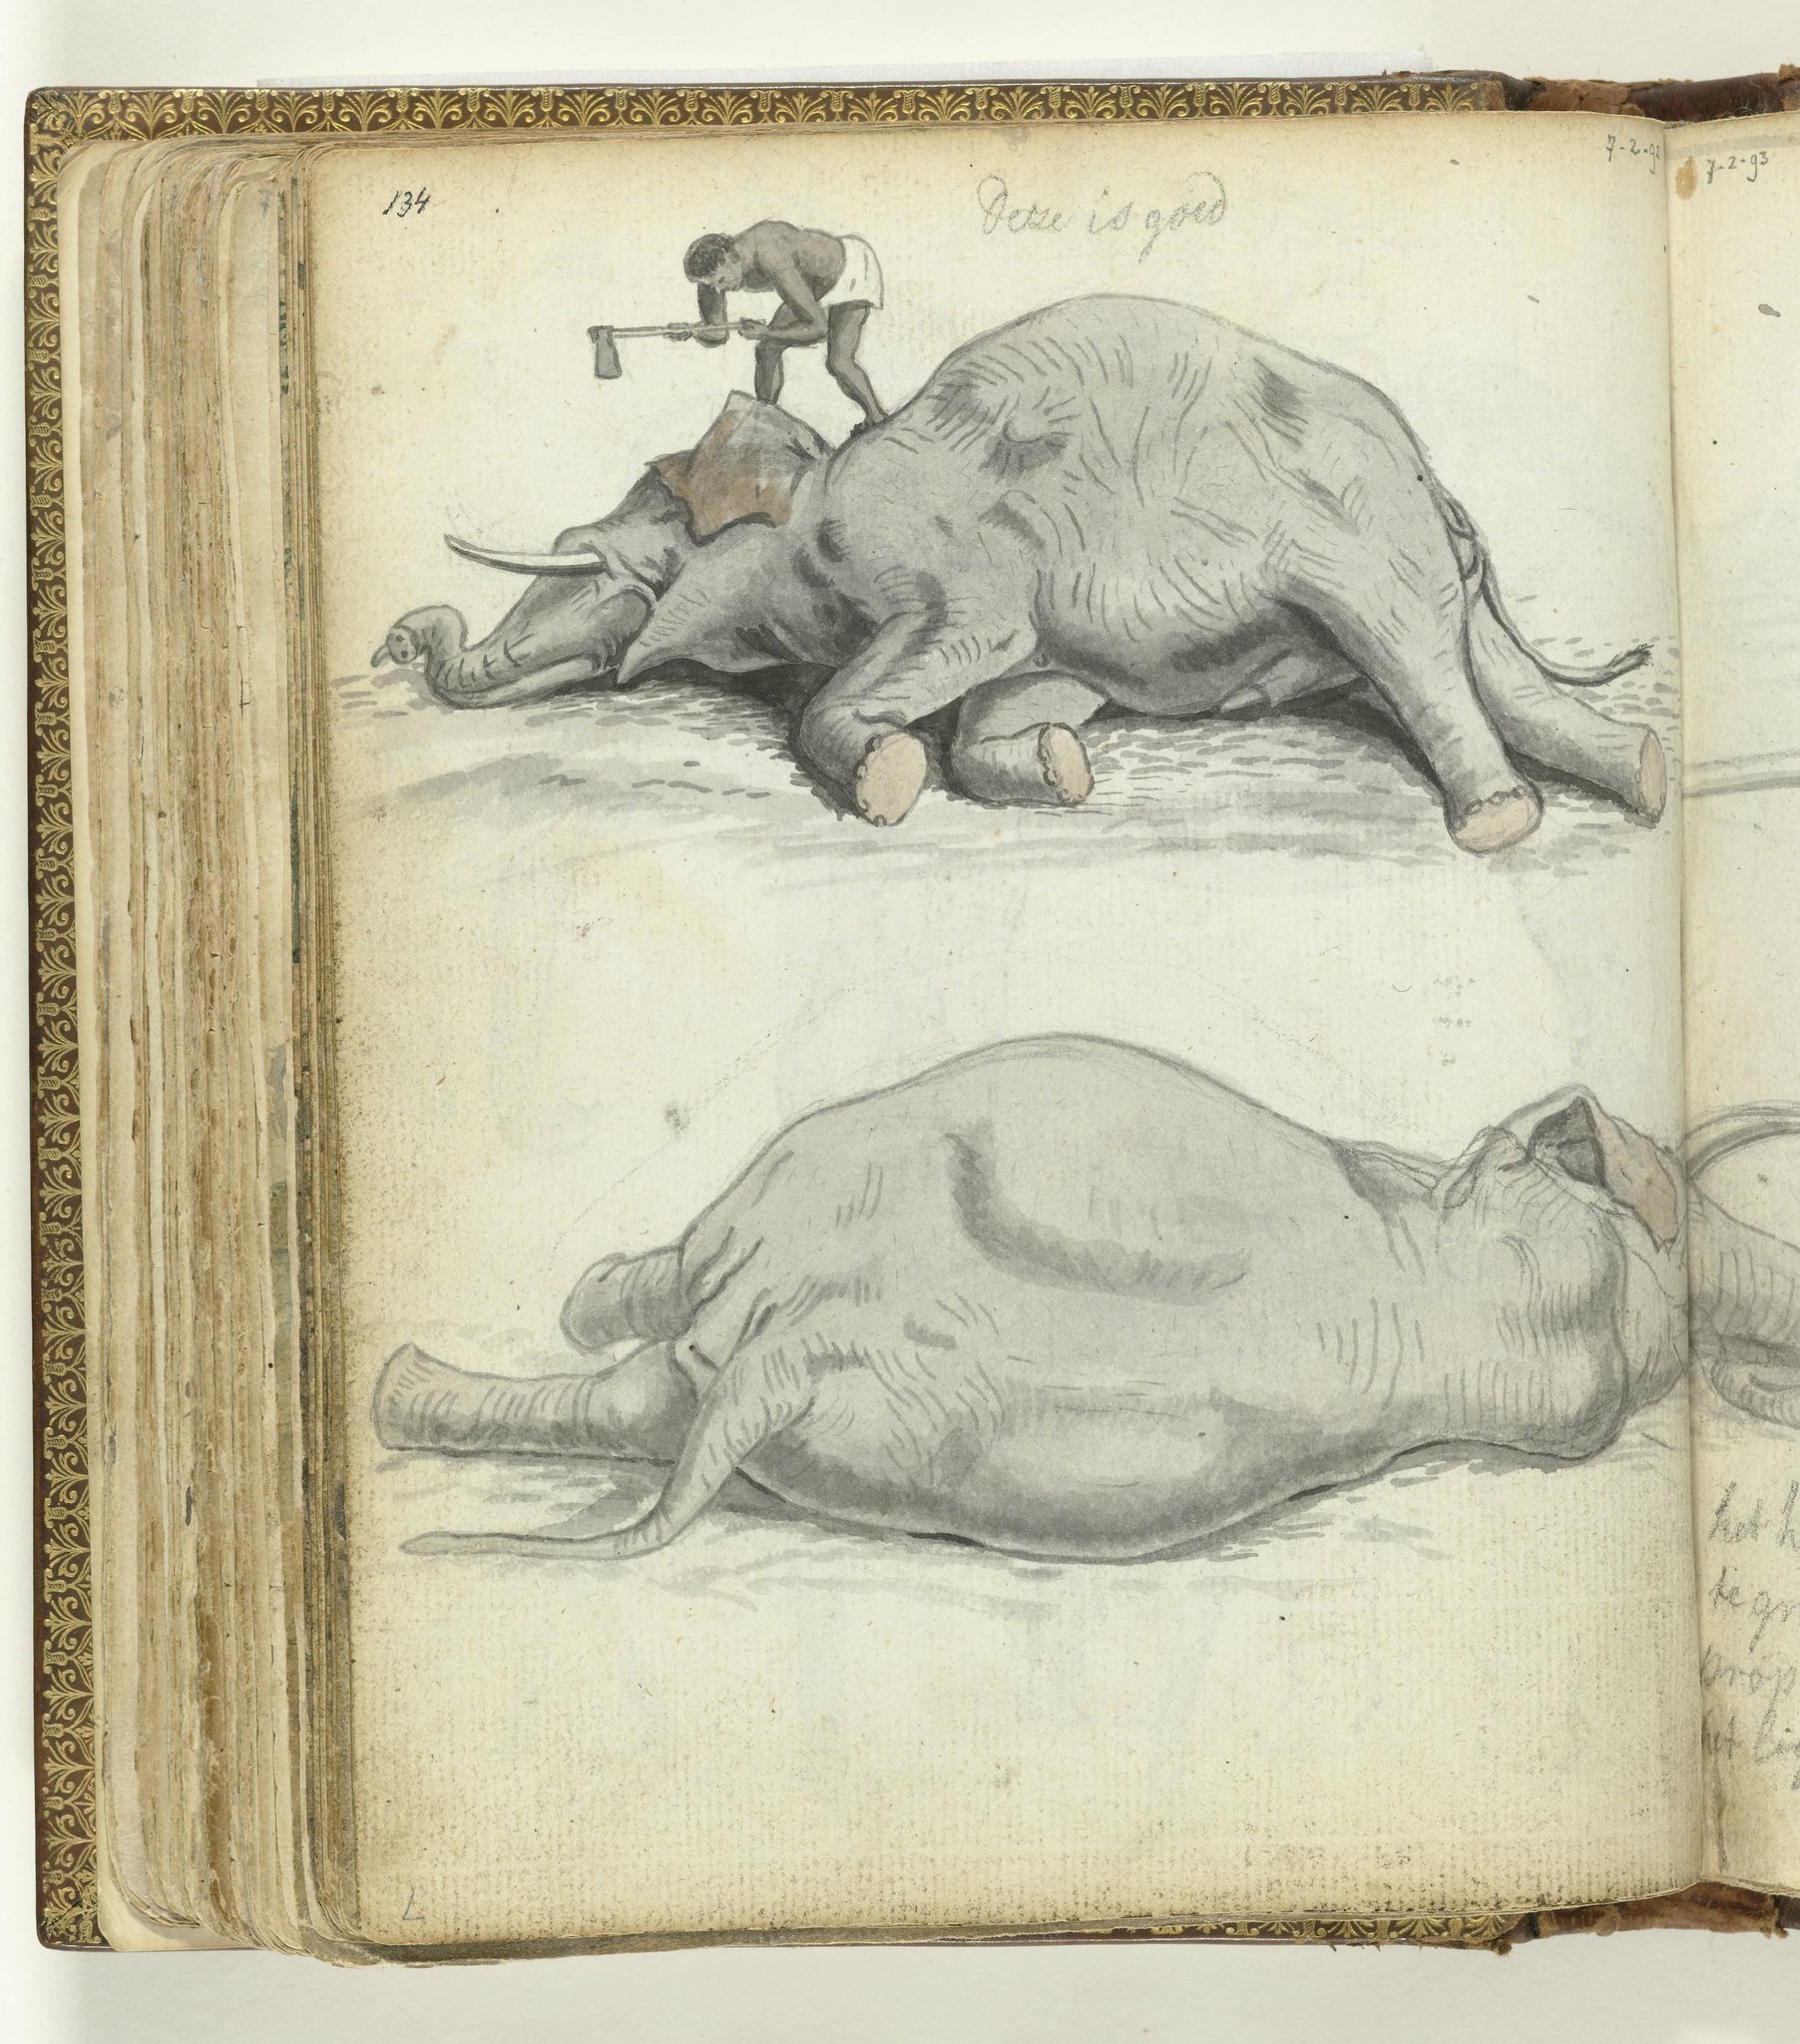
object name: drawing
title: Liggende olifant met hakkende Singalees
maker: jan brandes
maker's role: draughtsman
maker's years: 1743-1808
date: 1712-1785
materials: ink, paper, pencil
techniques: brush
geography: ja-ela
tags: trunked animals: elephant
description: Zwartwitte penseeltekening van een liggende olifant met een lap over zijn hoofd. De olifant is van tweemaal afgebeeld. Boven ligt hij met zijn poten naar de tekenaar en op zijn nek staat een Singalees in lendedoek in hem te hakken. Onder ligt de olifant met de rug naar de tekenaar toe. Zijn slurf loopt over naar de volgende pagina. Met opschrift. Onderdeel uit het schetsboek van Jan Brandes, dl. 2 (1808), p. 134-135.